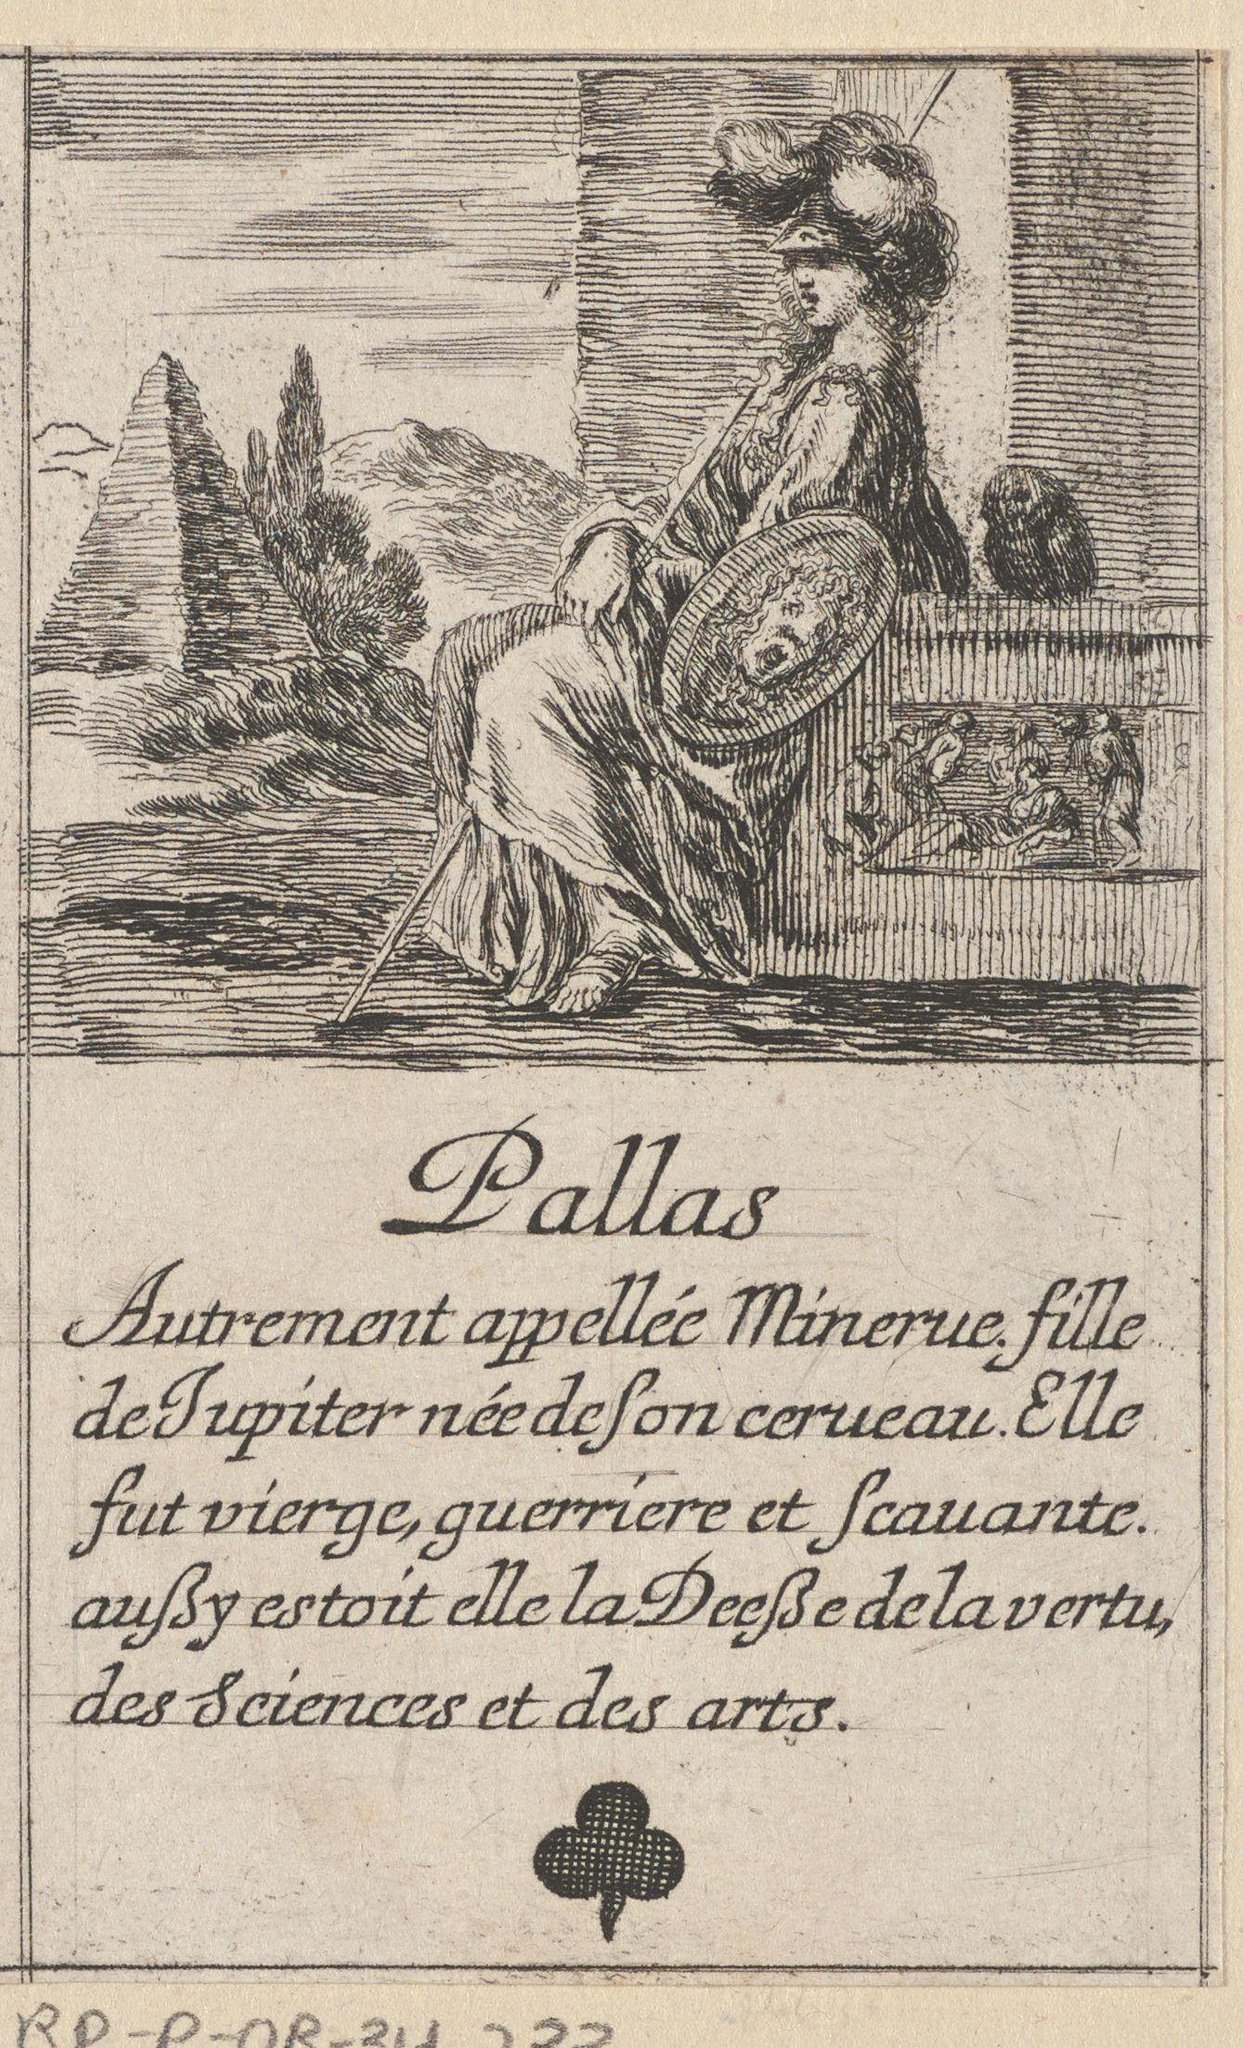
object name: playing card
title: Minerva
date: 1620-1664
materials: paper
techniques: etching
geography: paris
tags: (story of) minerva (pallas, athena), attributes of minerva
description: Deze prent maakt deel uit van een kaartspel met 52 kaarten met voorstellingen uit de Metamorfosen van Ovidius. De serie is uitgedacht door Jean Desmarests de Saint-Sorlin in opdracht van Kardinaal Mazarin. Het kaartspel werd gemaakt voor de jonge Lodewijk XIV, samen met het Jeu des Reynes Renommées, Jeu de la Géographie en Jeu des Rois de France.